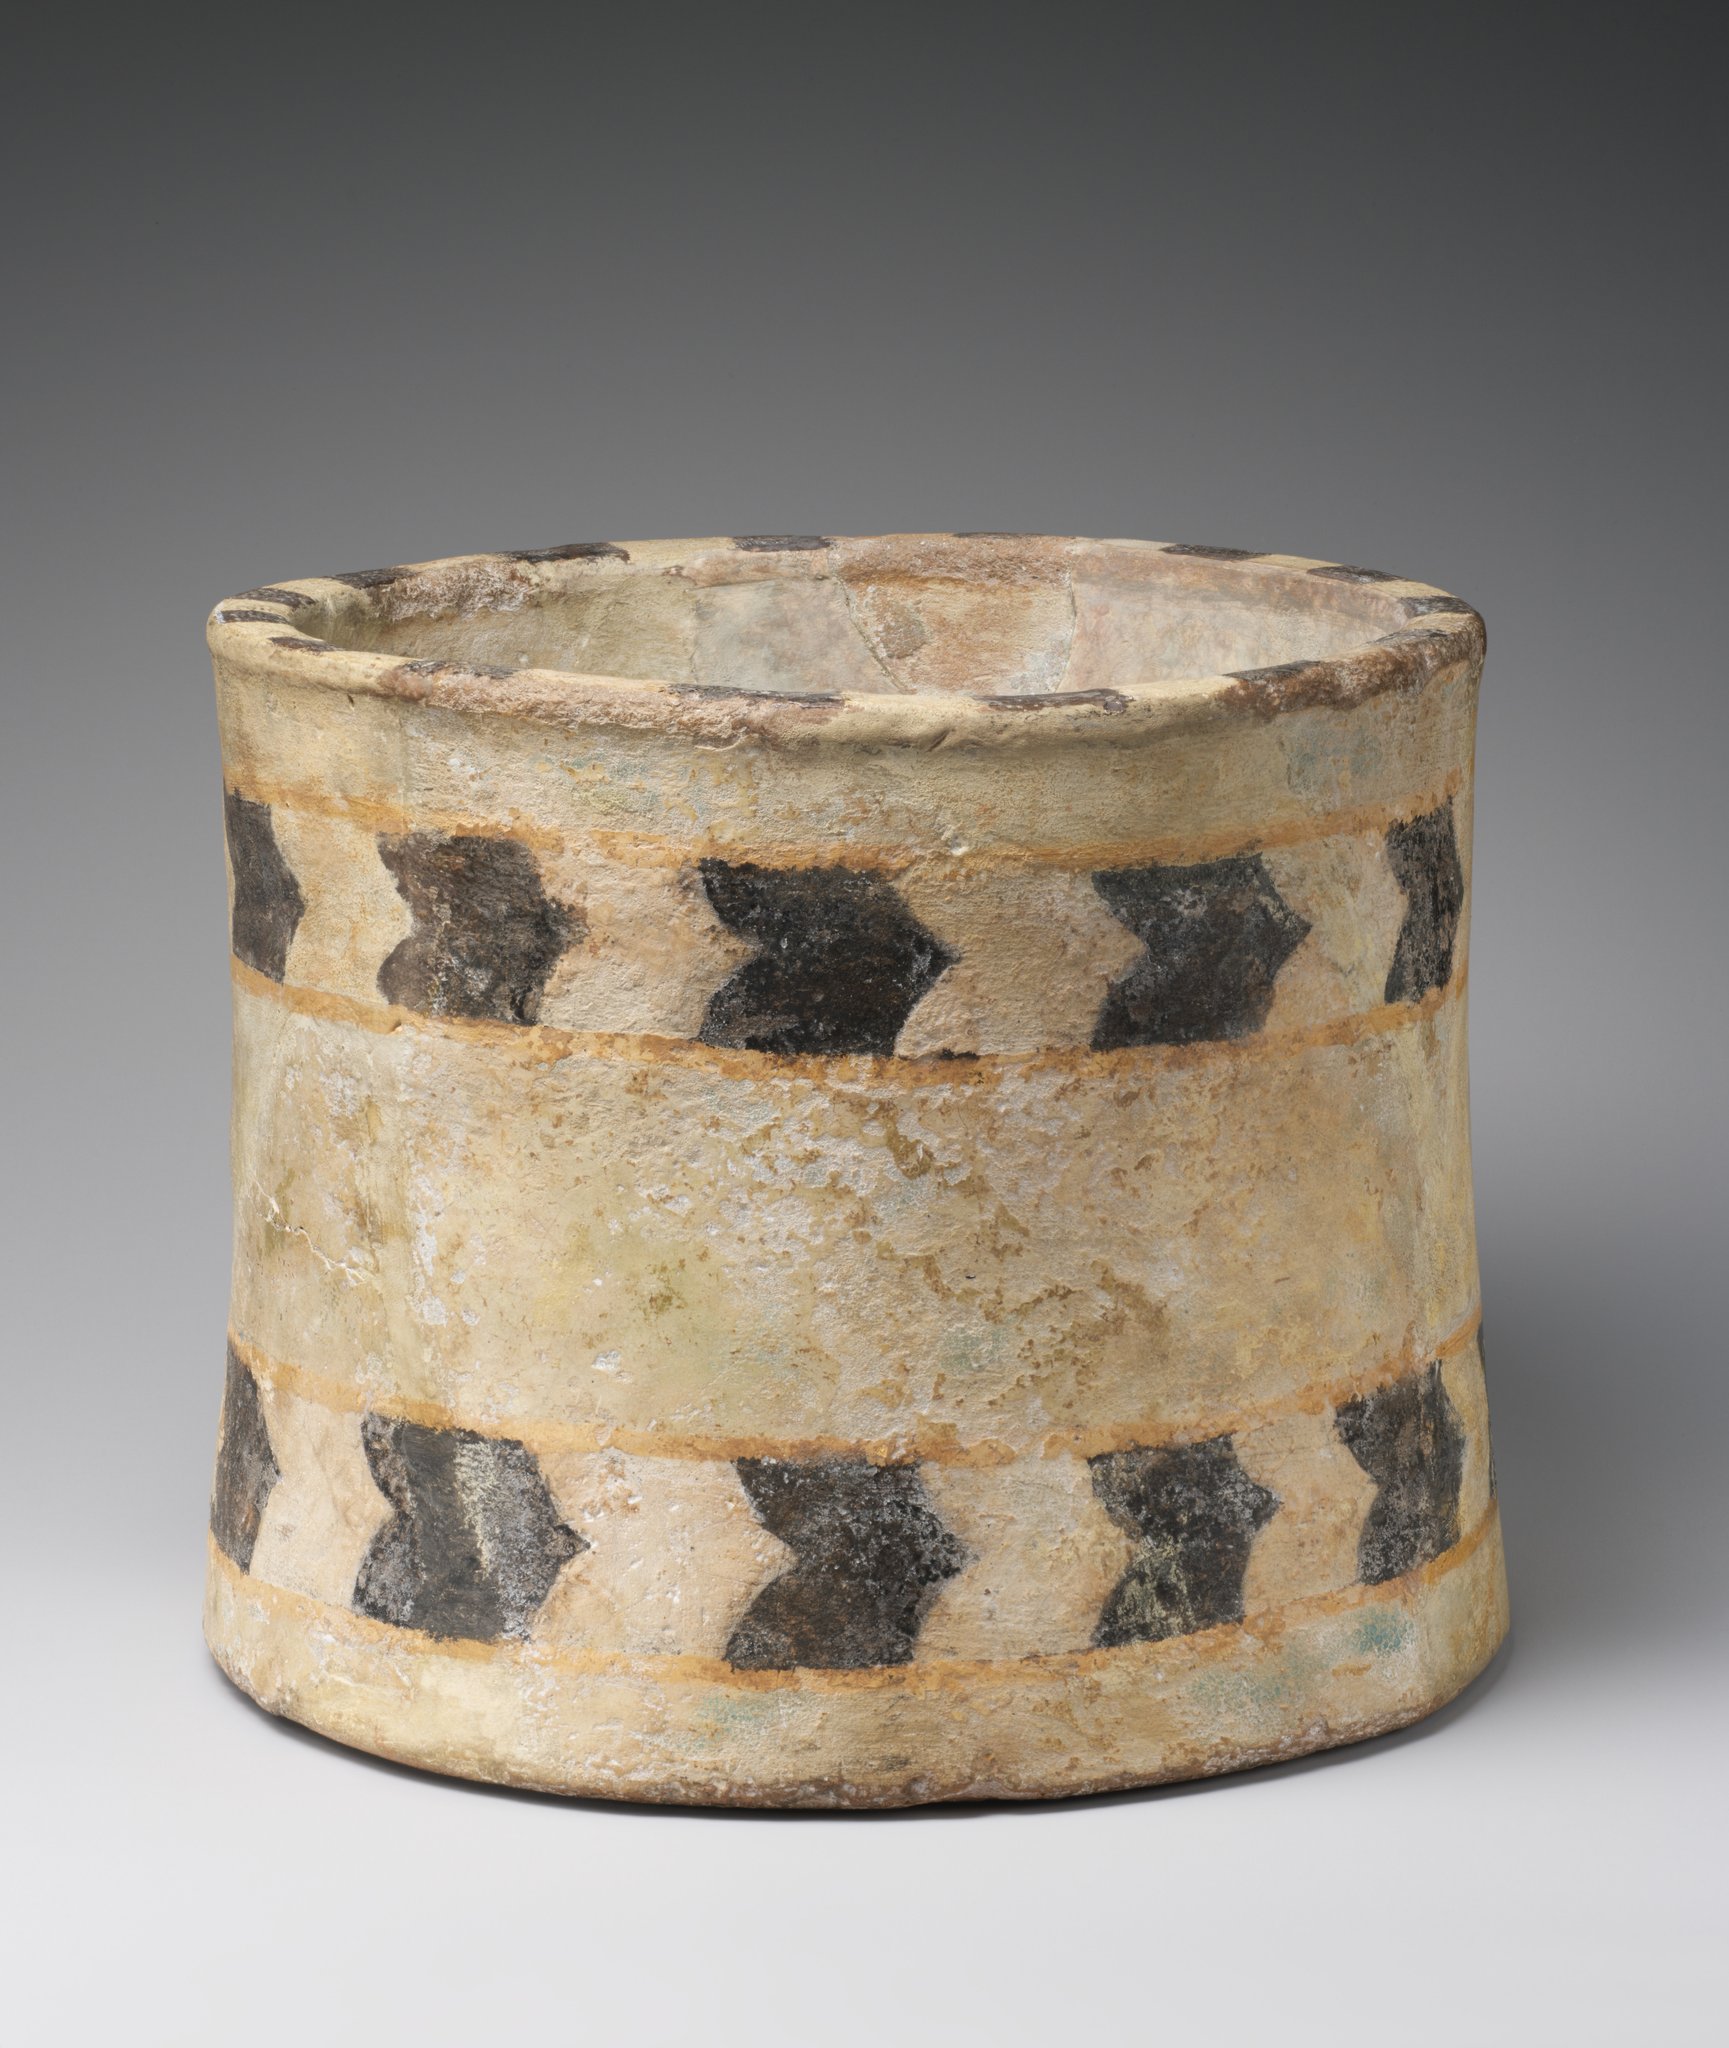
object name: vessel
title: Tub-like vessel with geometric decoration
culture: assyrian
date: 800-601 BCE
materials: ceramic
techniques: glazing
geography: mesopotamia